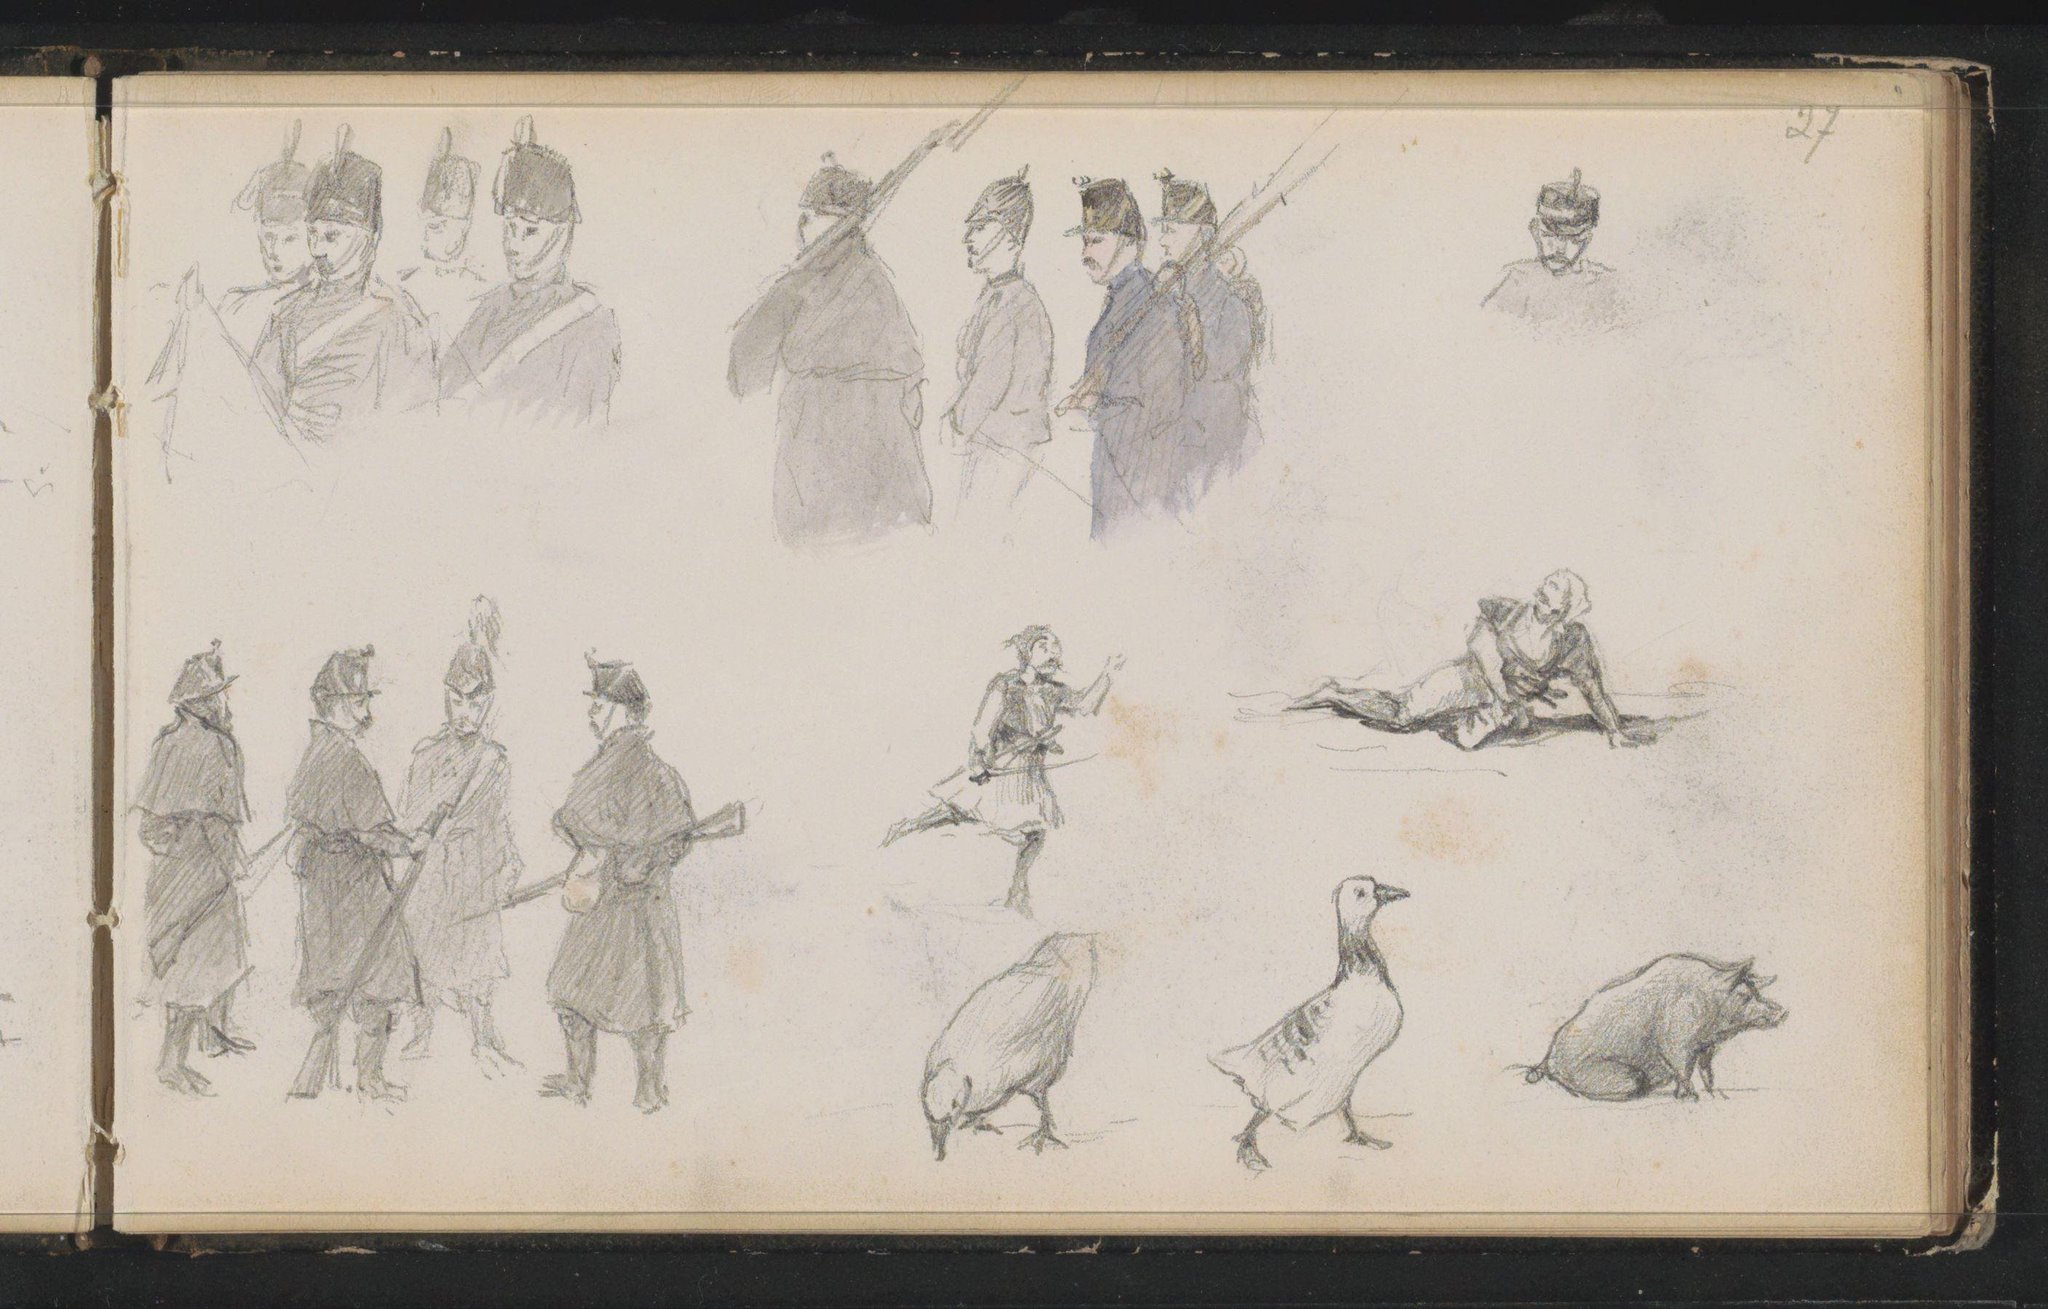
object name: sketchbook leaf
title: Militairen, ganzen en een zwijn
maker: marius bauer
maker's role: draughtsman, print maker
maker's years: 1867-1932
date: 1812-1880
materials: paper, pencil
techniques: brush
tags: pig, water-birds: goose, adult man, firearms, (military) uniforms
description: De militairen zijn met geweren getekend uit diverse aanzichten. Pagina 11 uit een schetsboek met 34 bladen.